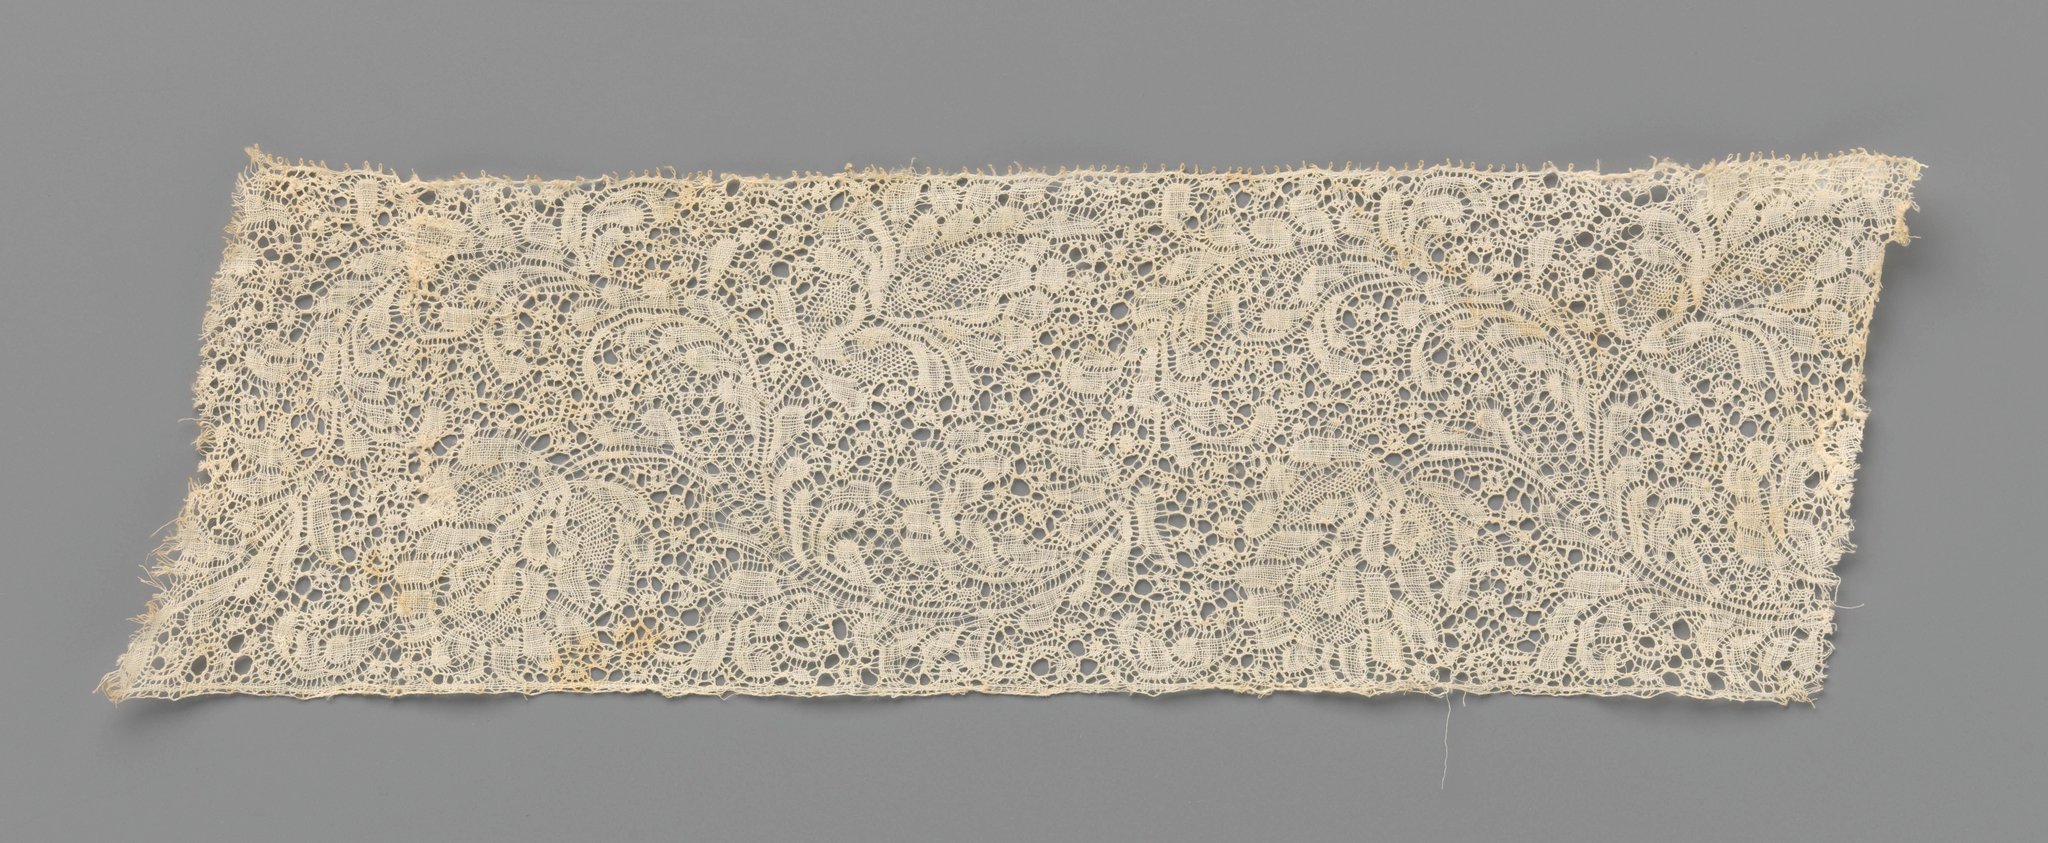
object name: strip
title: Strook kloskant met golvende gevederde bladeren en pluimbloemen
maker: Anonymous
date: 1740-1760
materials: linen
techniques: lace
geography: southern netherlands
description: Strook naturelkleurige kloskant: Binche-kant. Het zich herhalende en doorlopende patroon bestaat uit golvende gevederde bladeren, met onder elke golftop een pluimvormige bloem met een langgerekt spitsovaalvormig centrum en tussen de golftoppen een dikke pluimvormige bloem. De motieven zijn met elkaar verbonden door een siergrond, een sneeuwvlokkengrond. De motieven zijn gemaakt in linnenslag en netslag met opengewerkte randjes. Er is één soort siergrond toegepast rondom de golvende bladeren. Boven- en onderzijde van de strook zijn recht afgewerkt, waarbij de onderzijde is voorzien van picots.